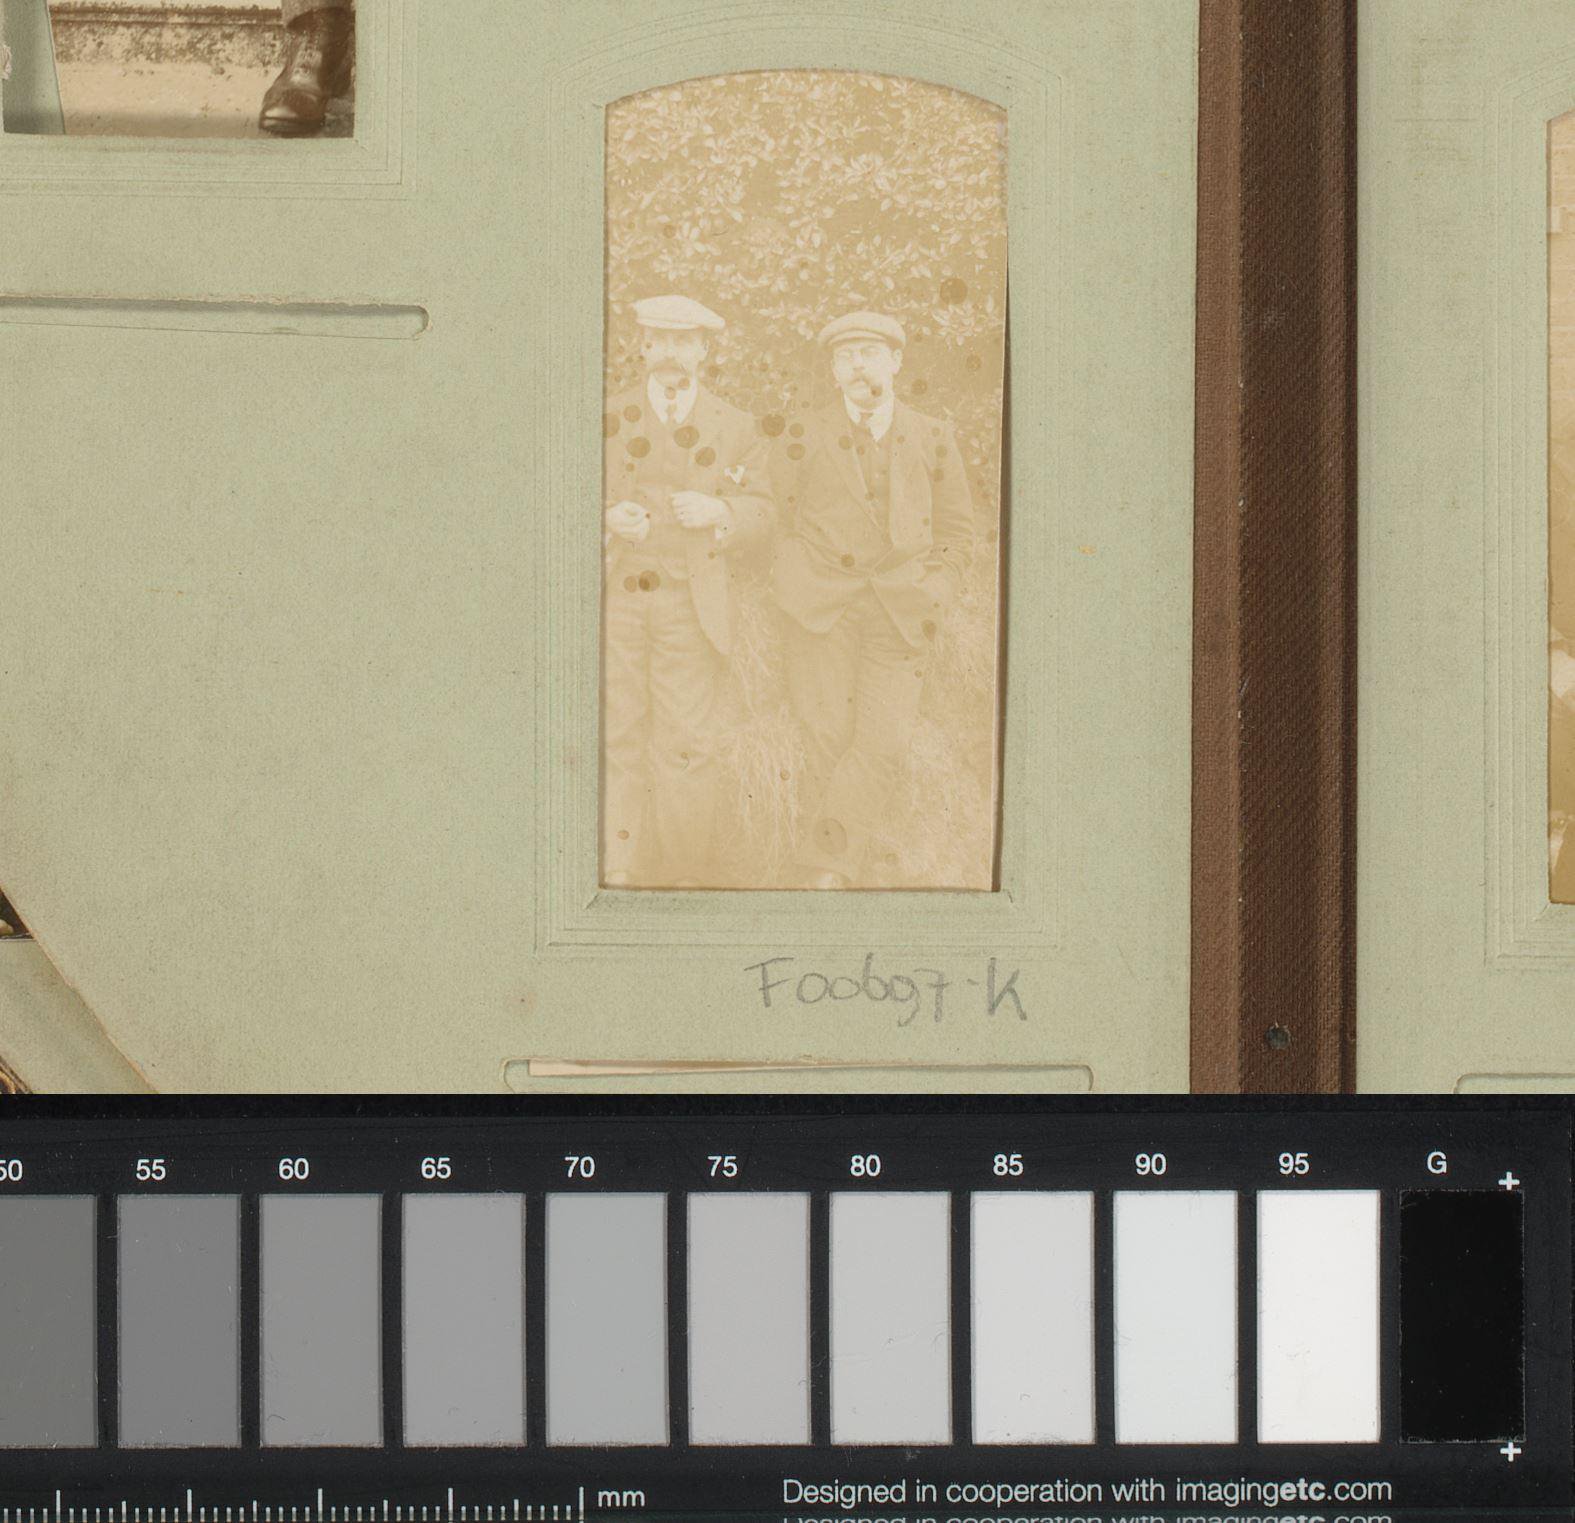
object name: photograph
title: Twee mannen met petten en snorren in een tuin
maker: Anonymous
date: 1890-1910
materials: photographic support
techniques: gelatin silver print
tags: trees, moustache, adult man, historical persons, head-gear: cap